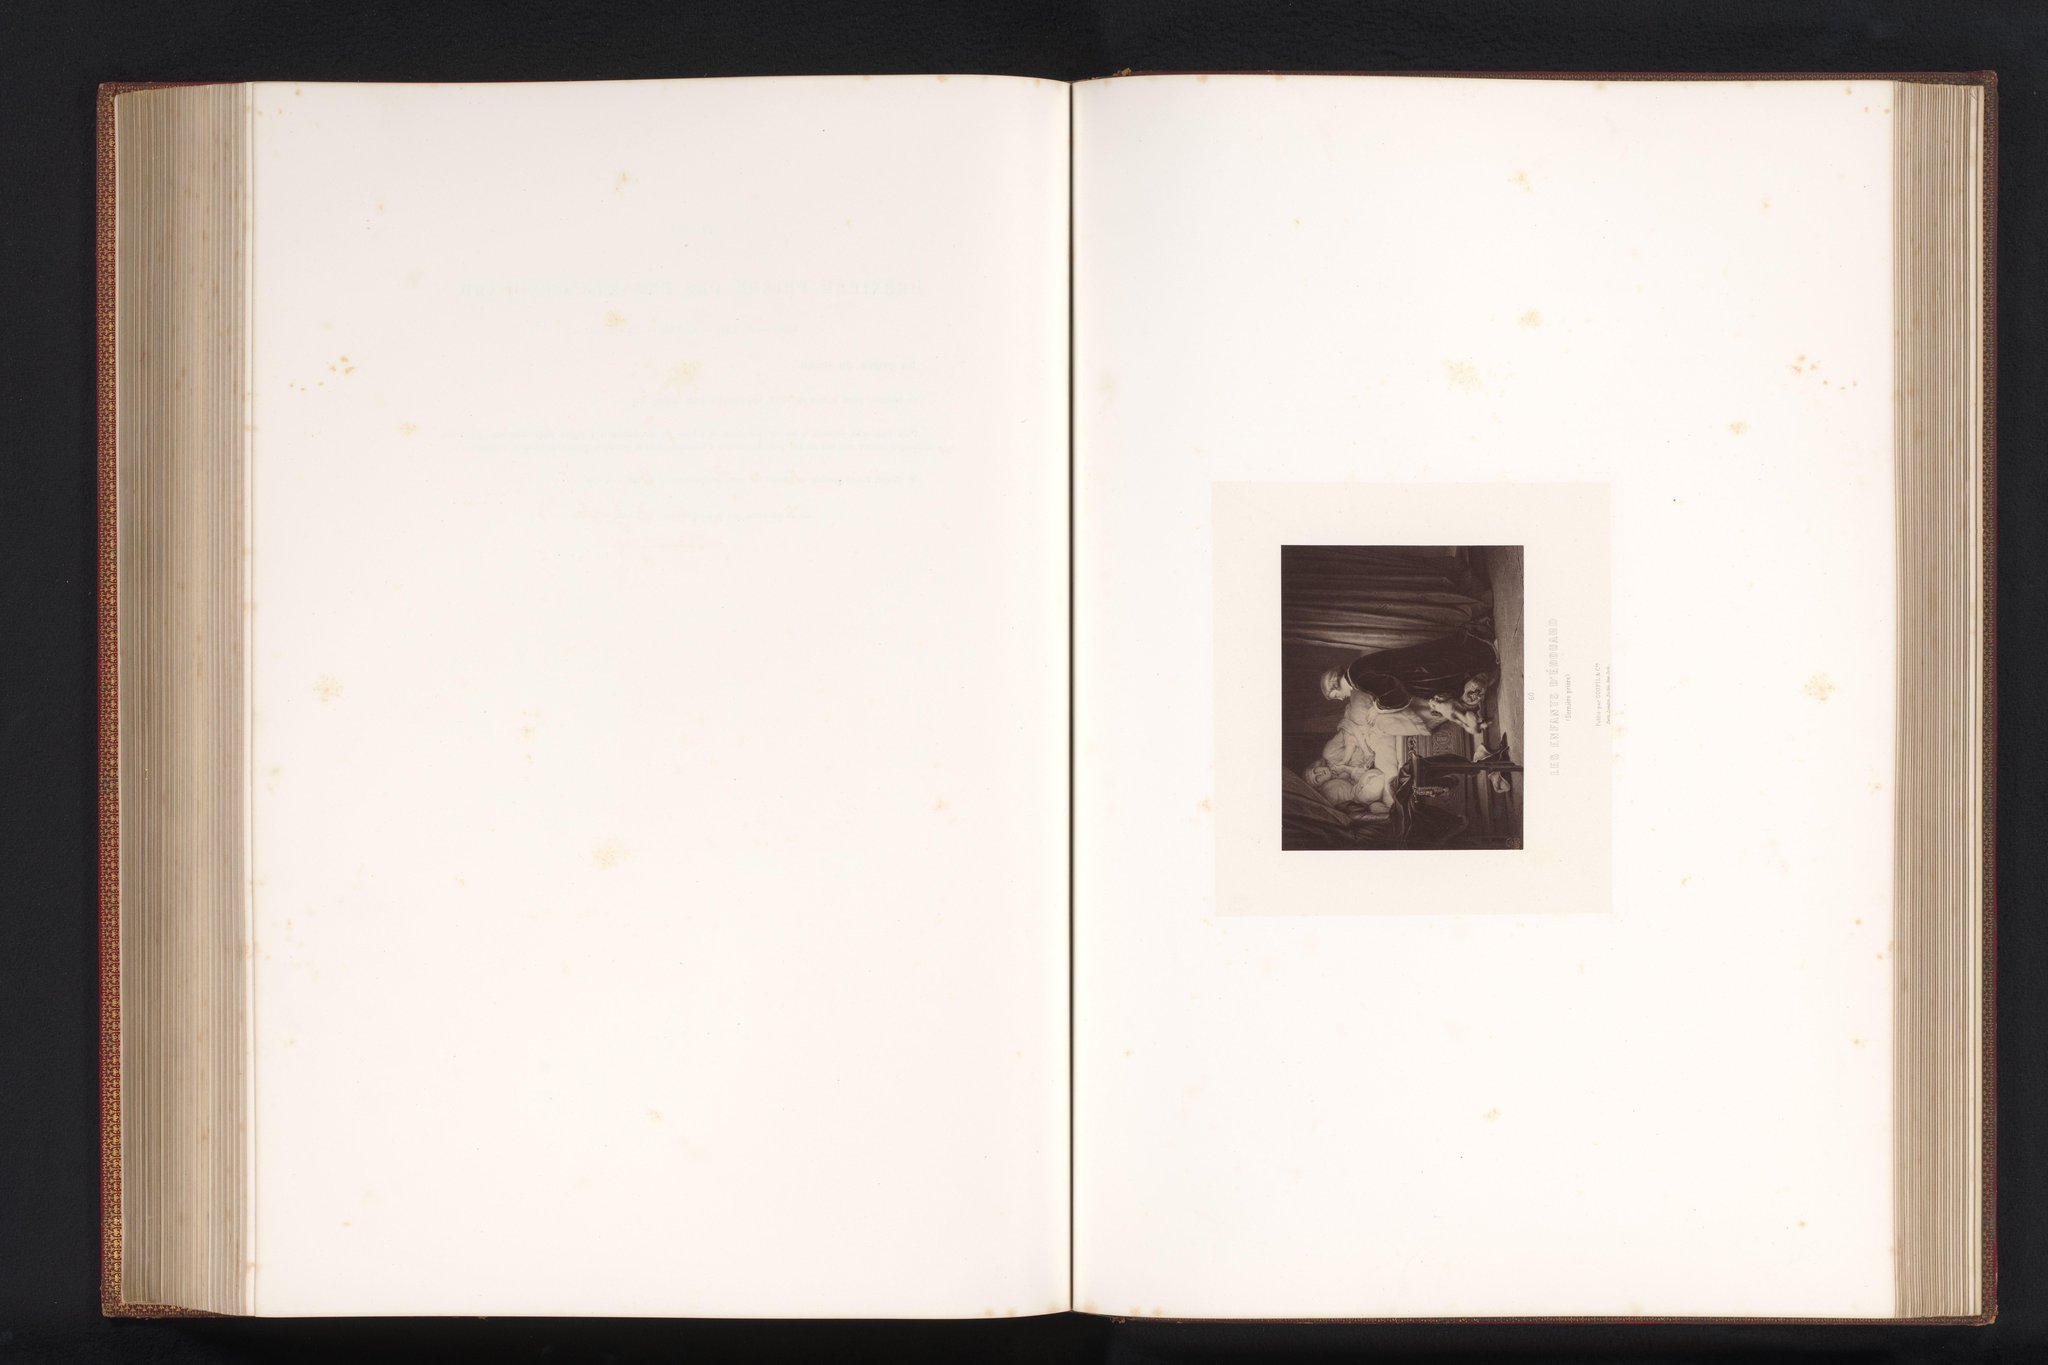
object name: page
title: Dernière prière des enfants d'Édouard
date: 1853-1858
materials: paper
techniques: albumen print, engraving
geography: paris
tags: westminster abbey, london, edward v, boy (child between toddler and youth), (private) prayer; 'oratione', 'preghiere', 'preghiere a dio' (ripa)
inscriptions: initials: ‘GC’